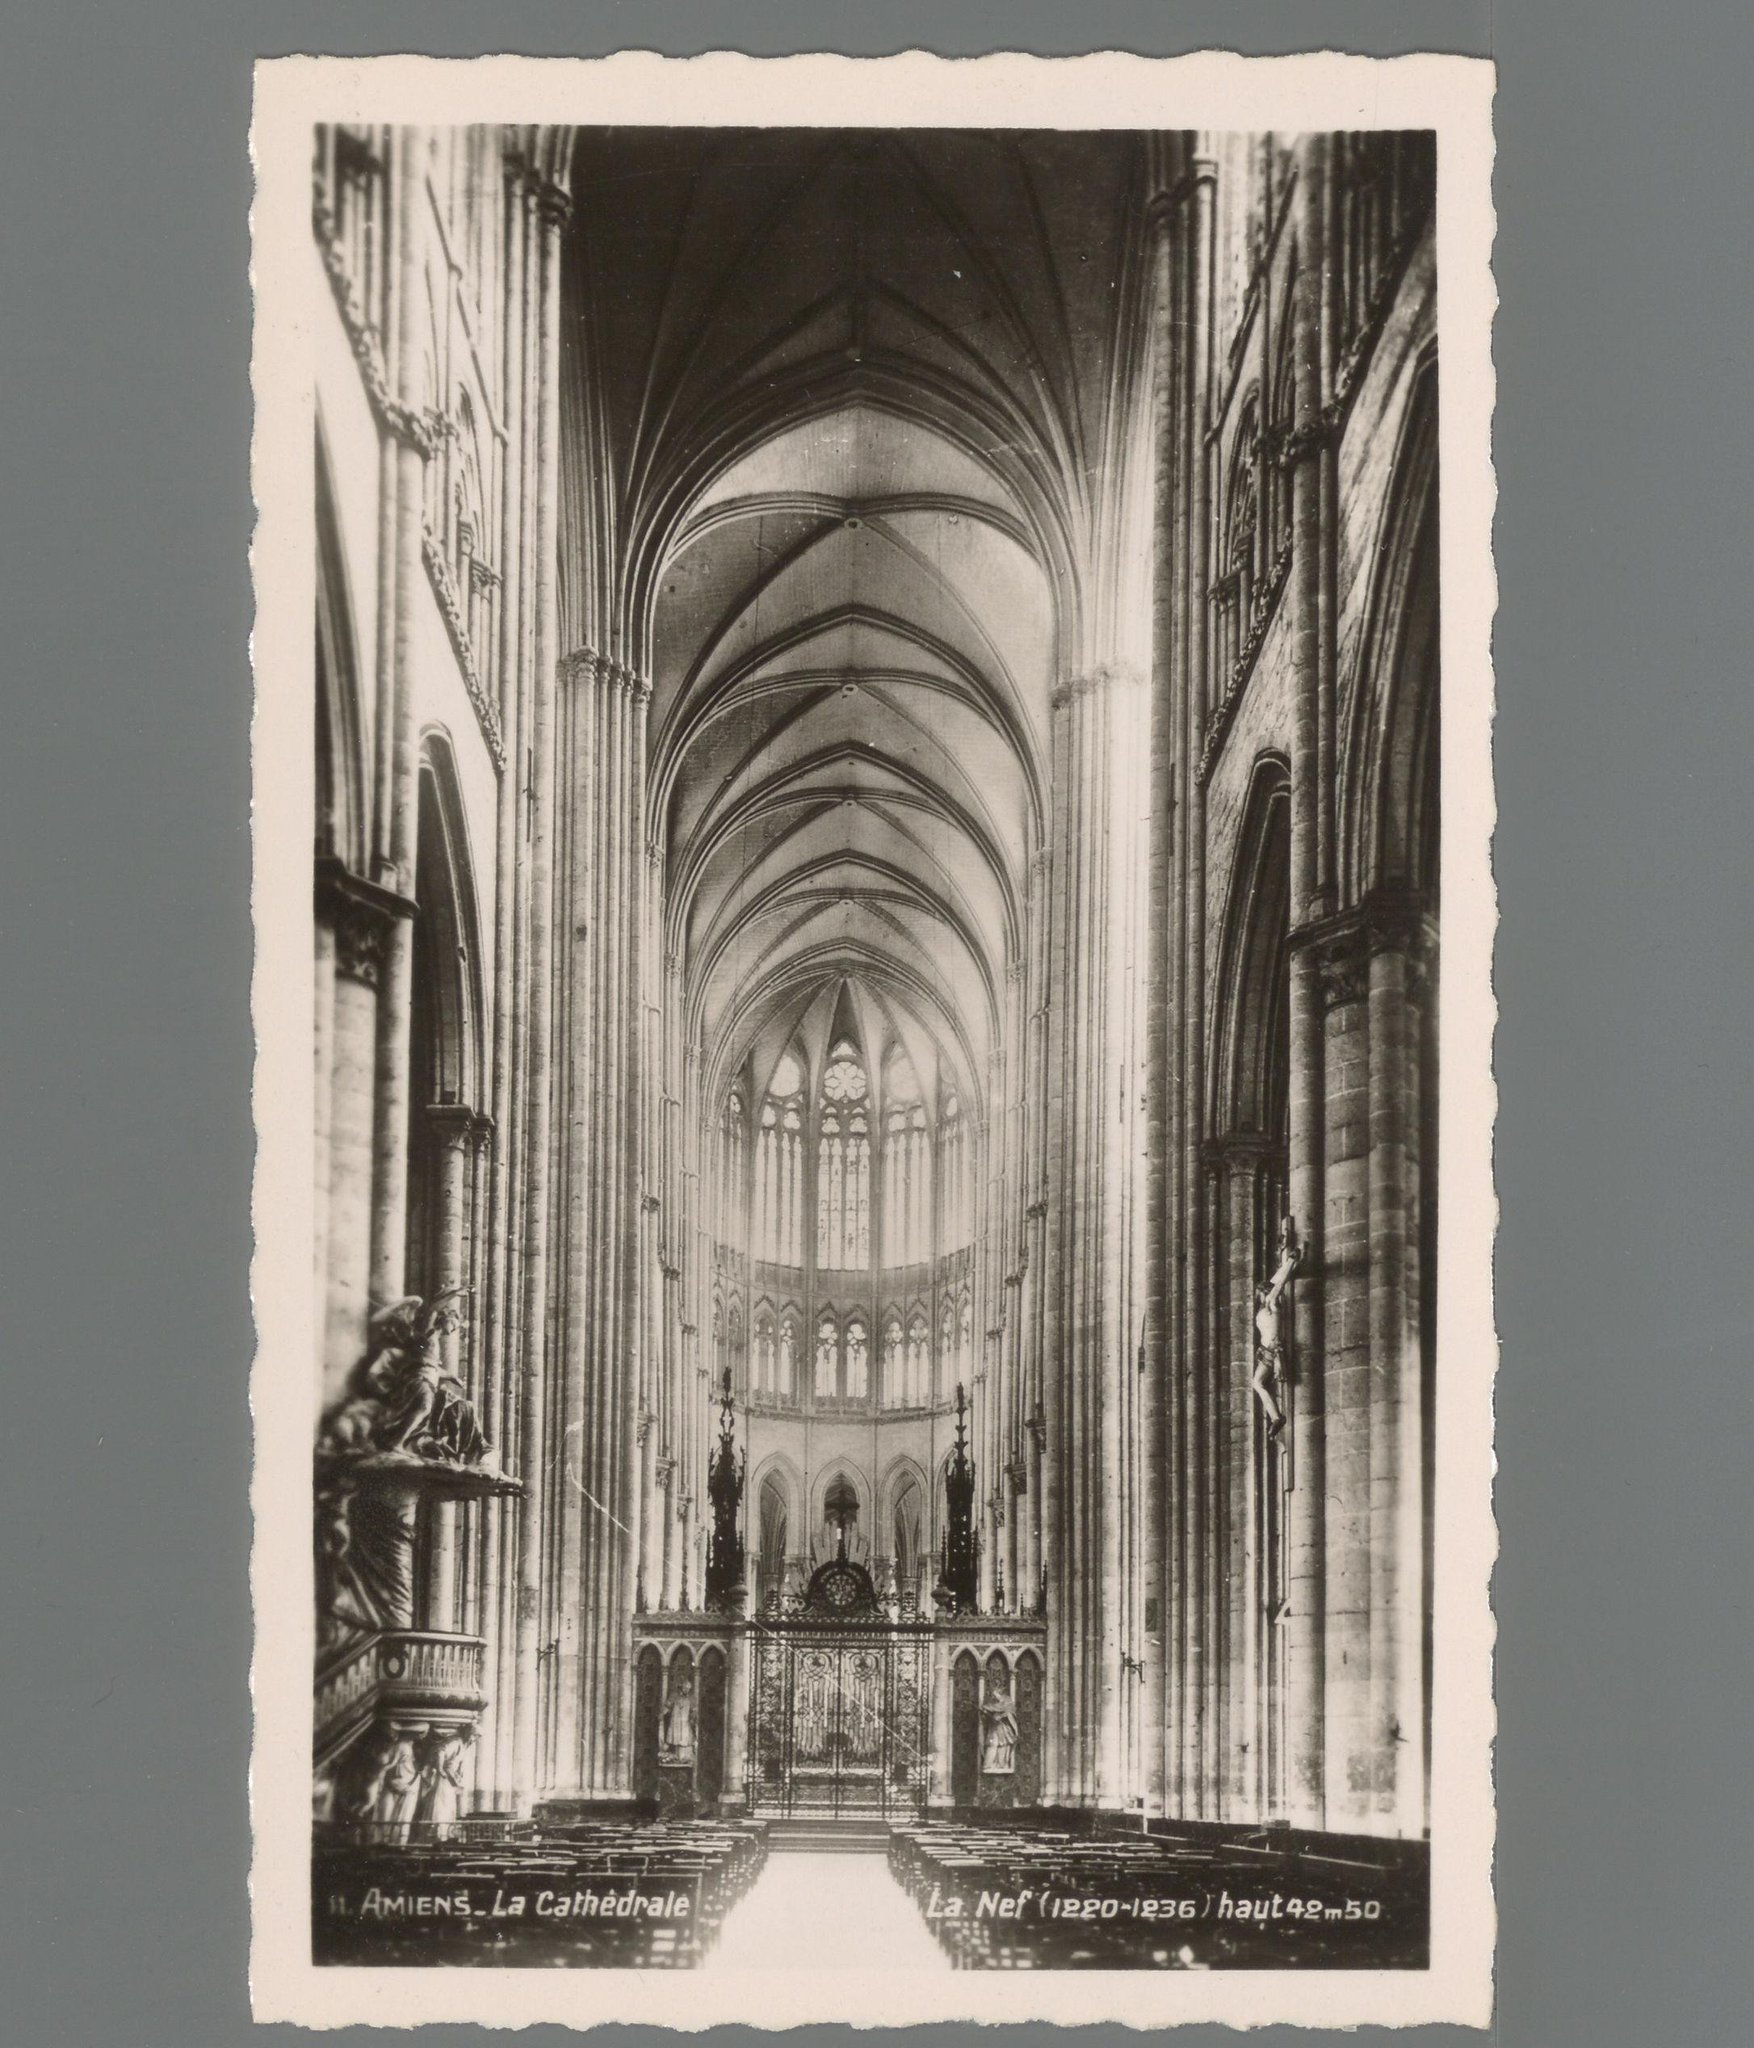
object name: ansichtkaart, prentbriefkaart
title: Amiens. La Cathédrale. La Nef (1220-1236) haut 42m50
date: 1903-1930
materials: photographic support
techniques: photography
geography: amiens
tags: parts of church interior: nave, notre-dame d'amiens